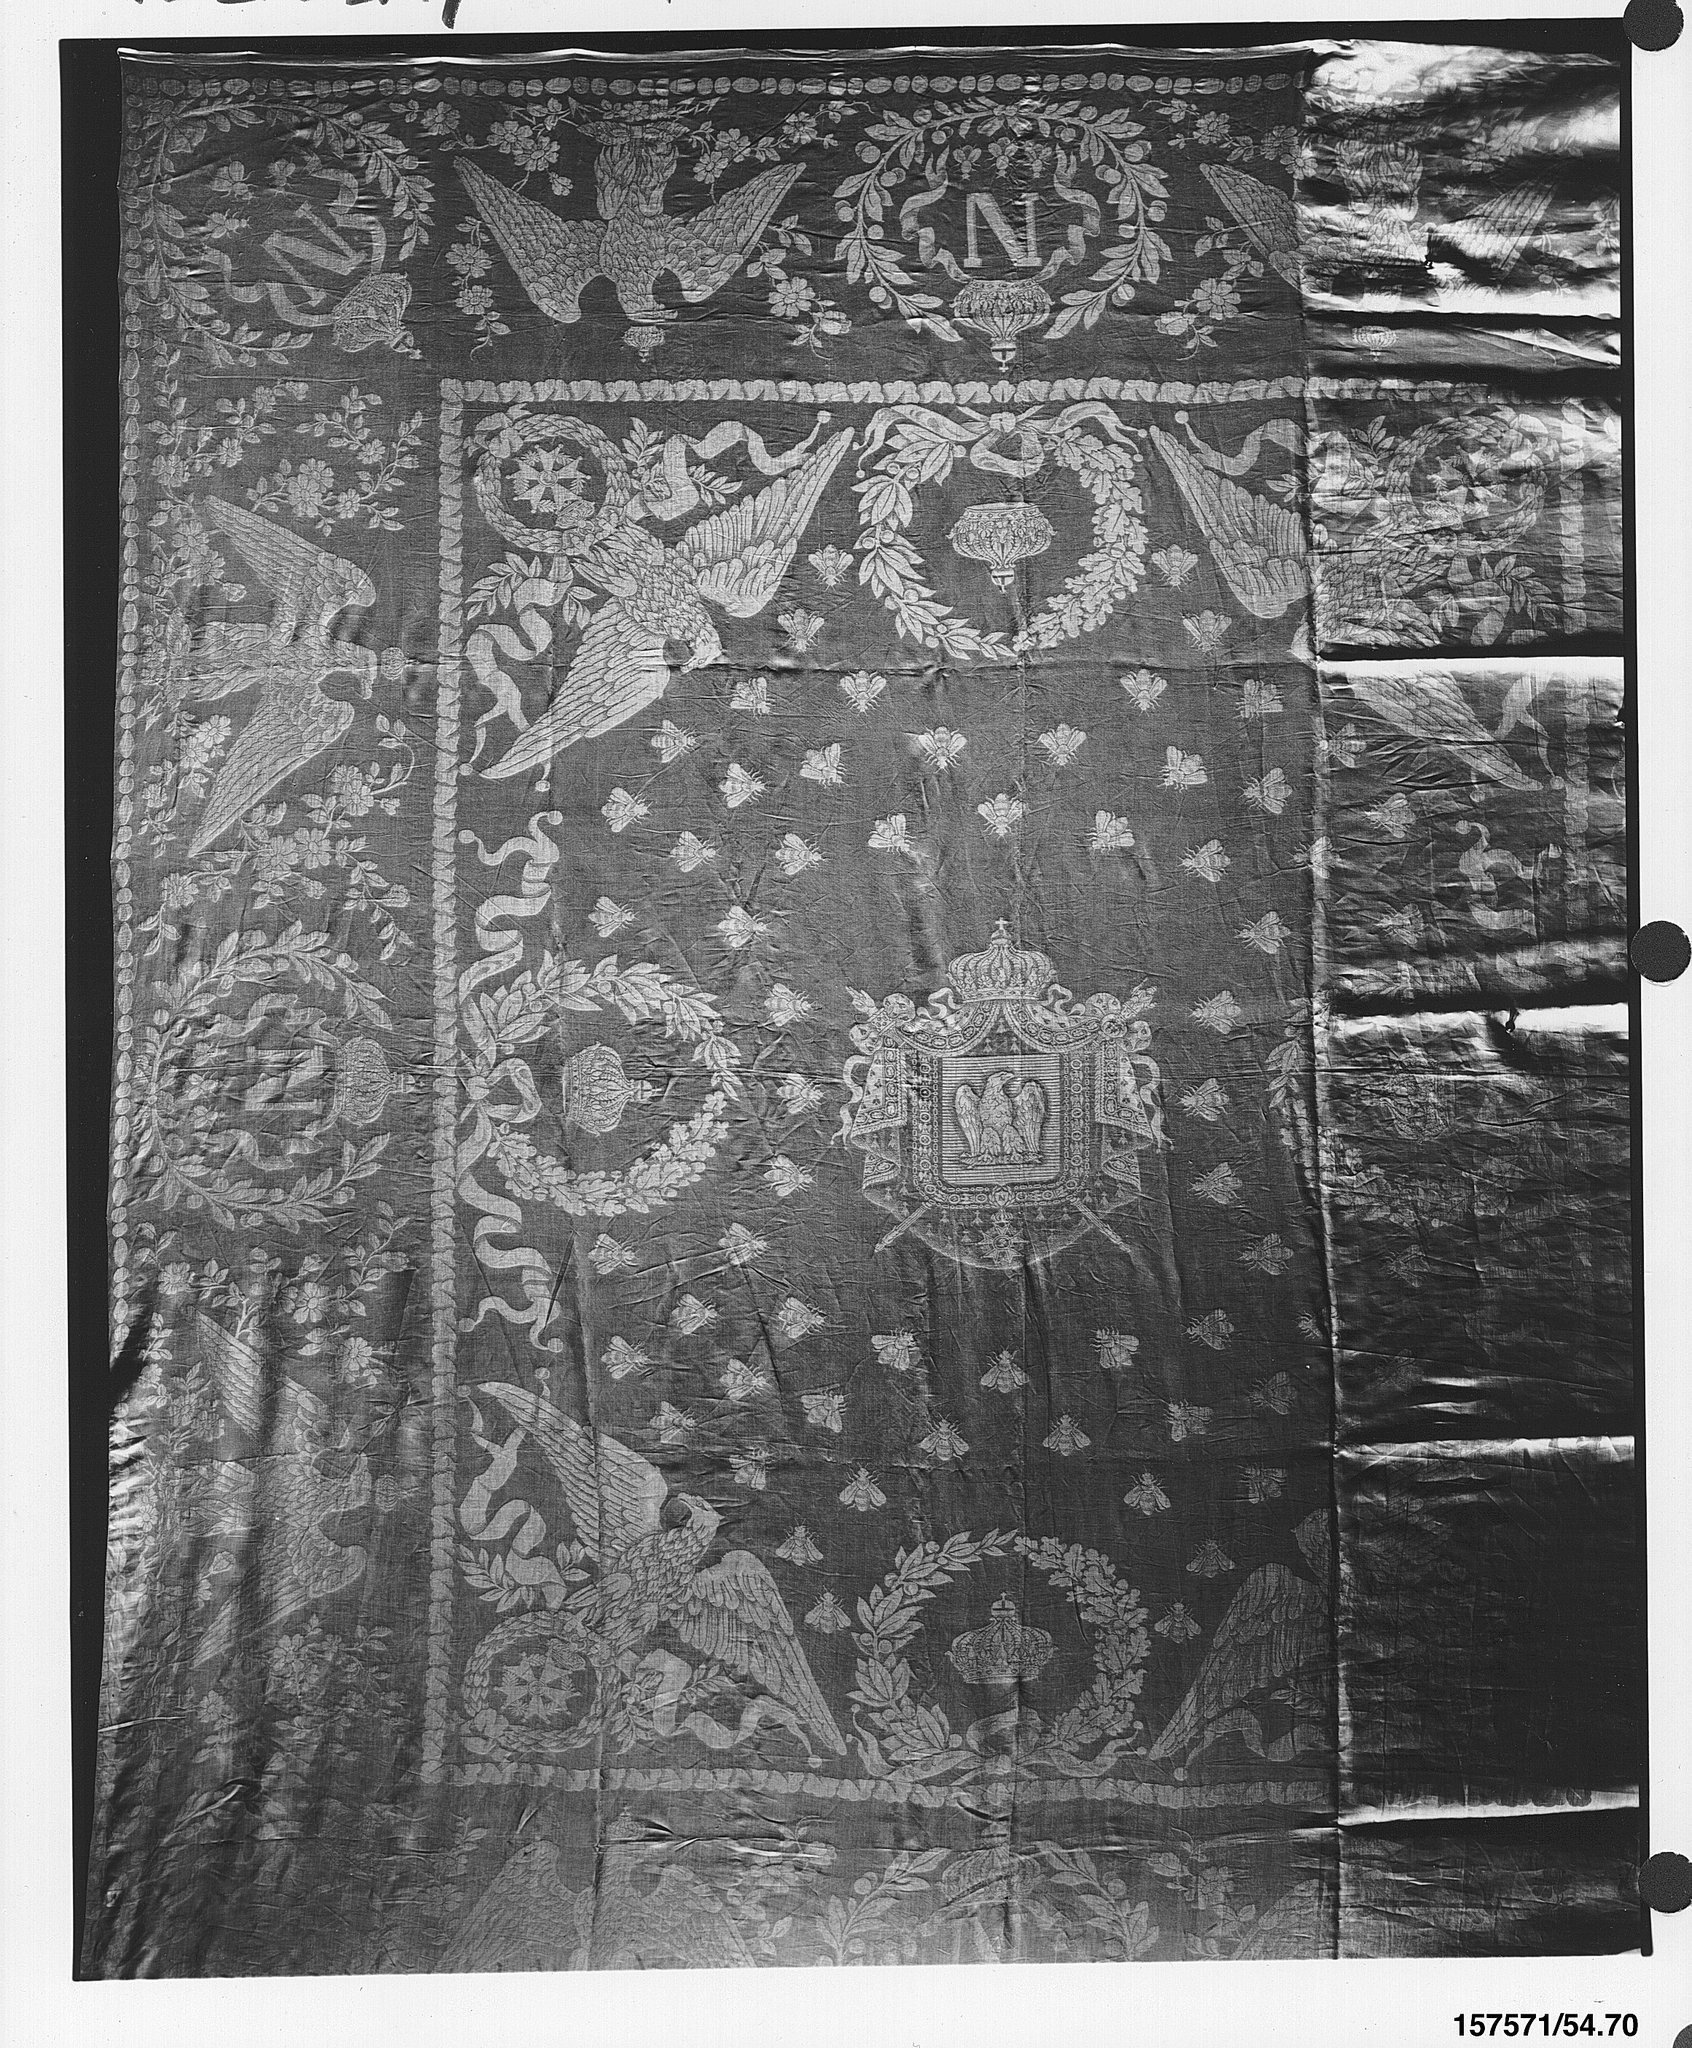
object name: tablecloth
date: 1852-1870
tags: eagles,bees,coat of arms